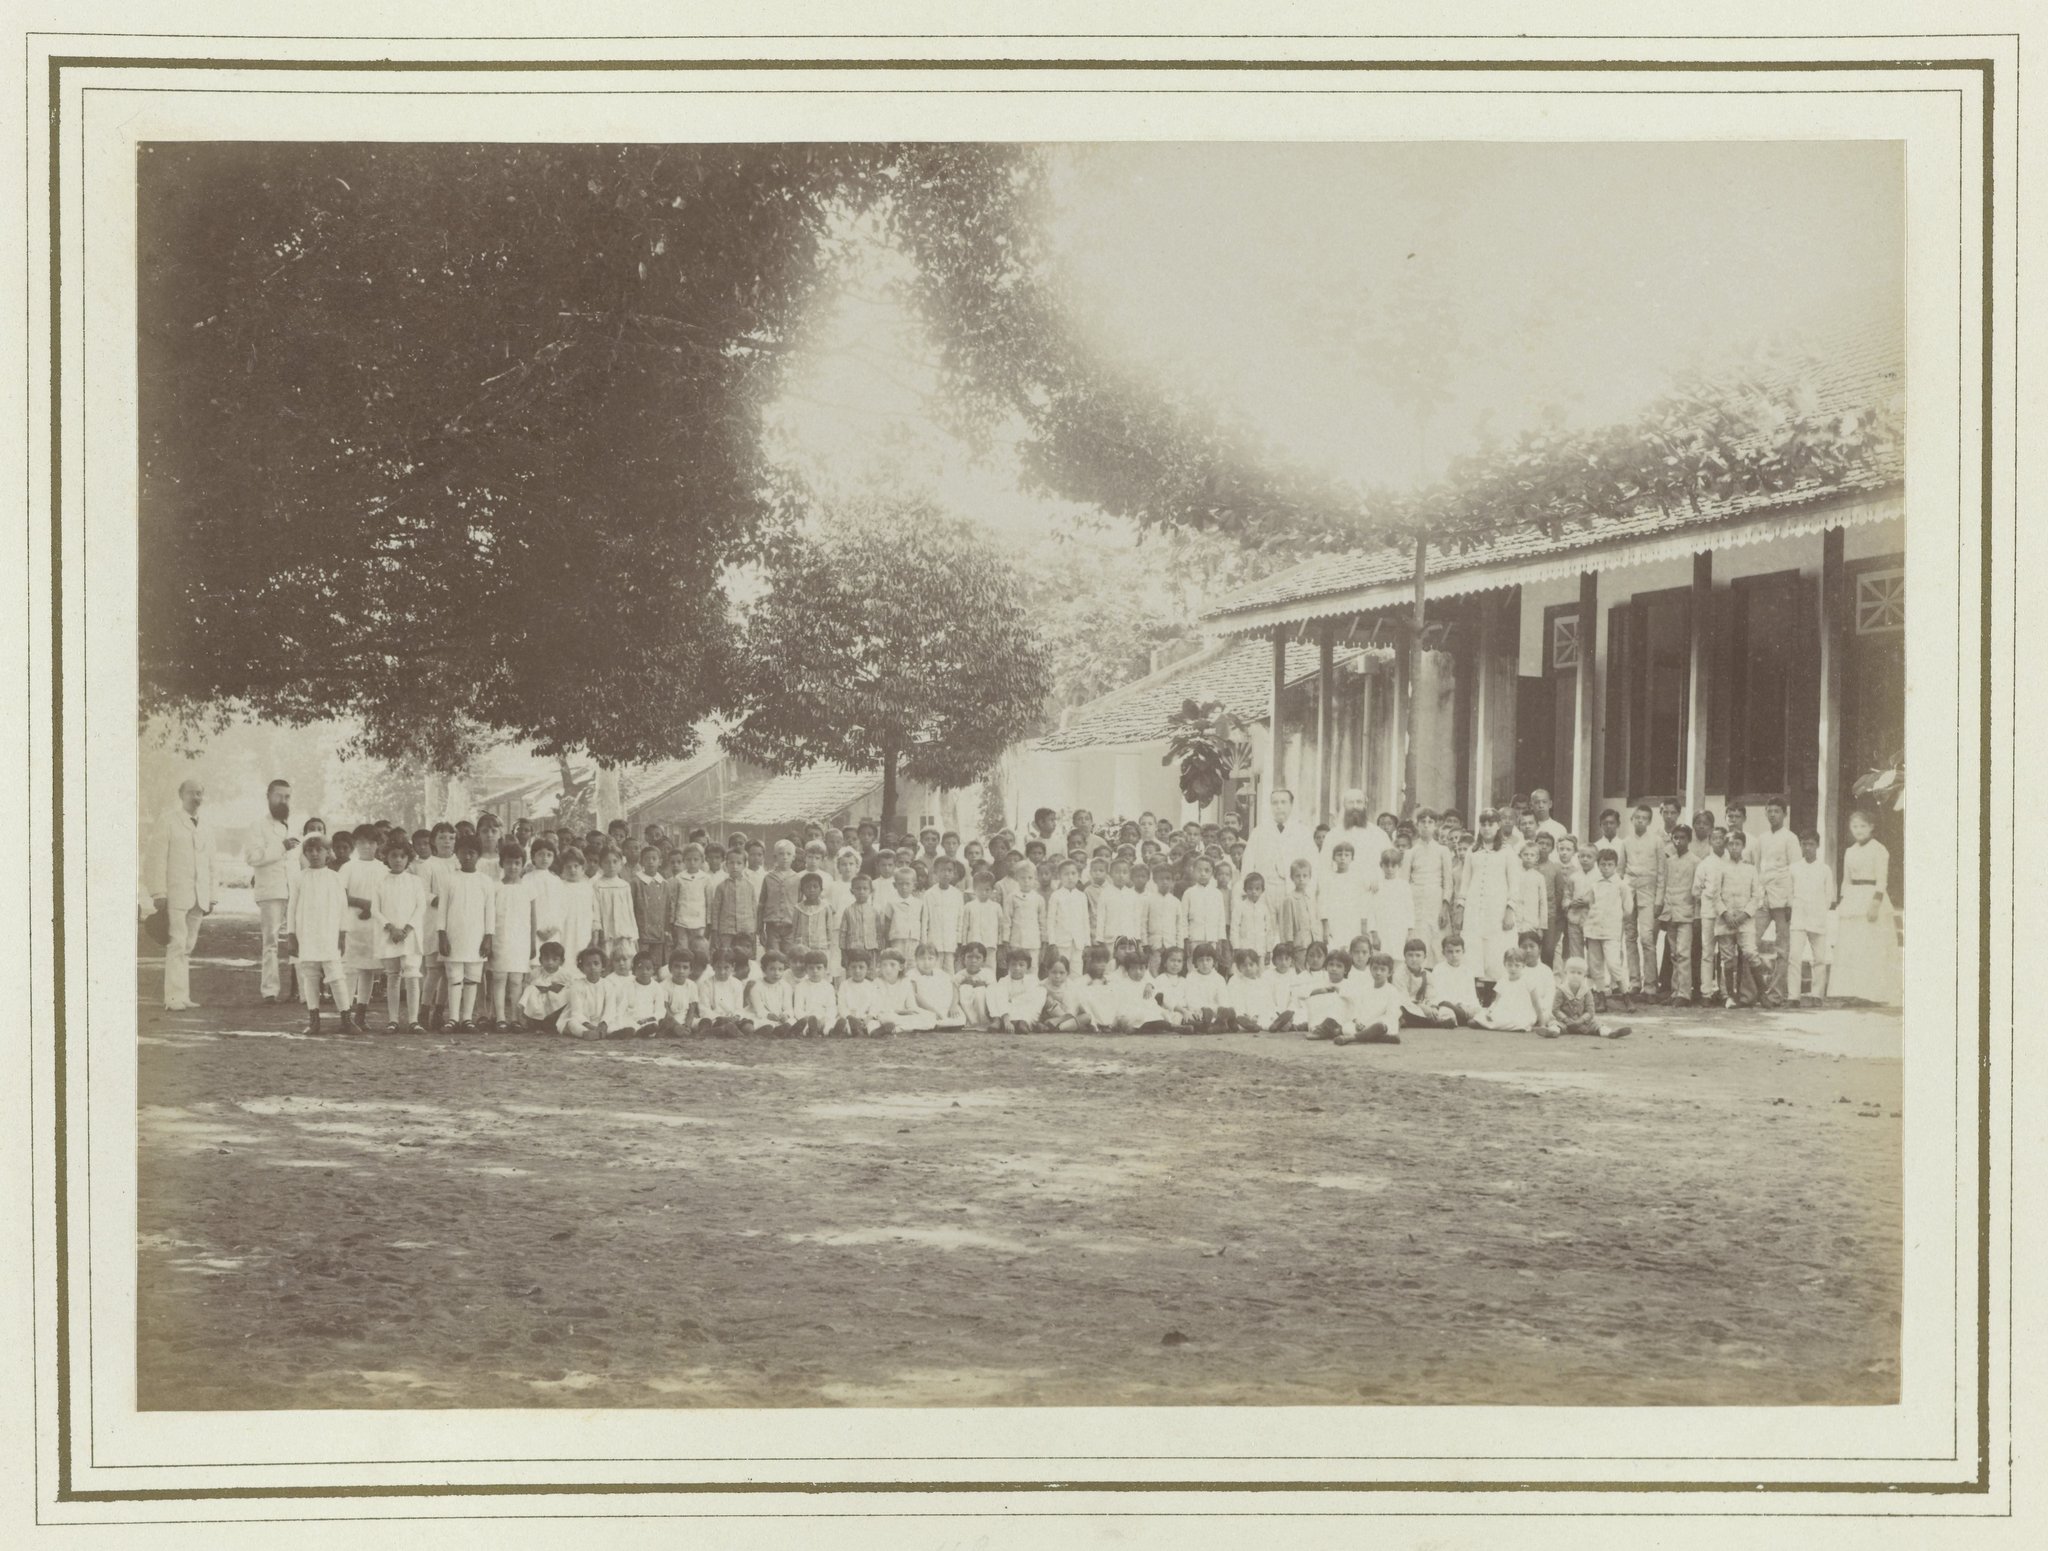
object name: photograph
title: School met kinderen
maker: kassian céphas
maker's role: fotograaf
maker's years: 1845-1912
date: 1886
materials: photographic support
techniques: albumen print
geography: jogjakarta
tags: elementary school; class, form (+ pupil)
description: Groepsfoto van schoolkinderen en onderwijzers staande voor hun schoolgebouw, in Jogyakarta. Onderdeel van het fotoalbum aangeboden aan J.M. Pijnacker Hordijk bij zijn vertrek uit Jogyakarta in 1886.